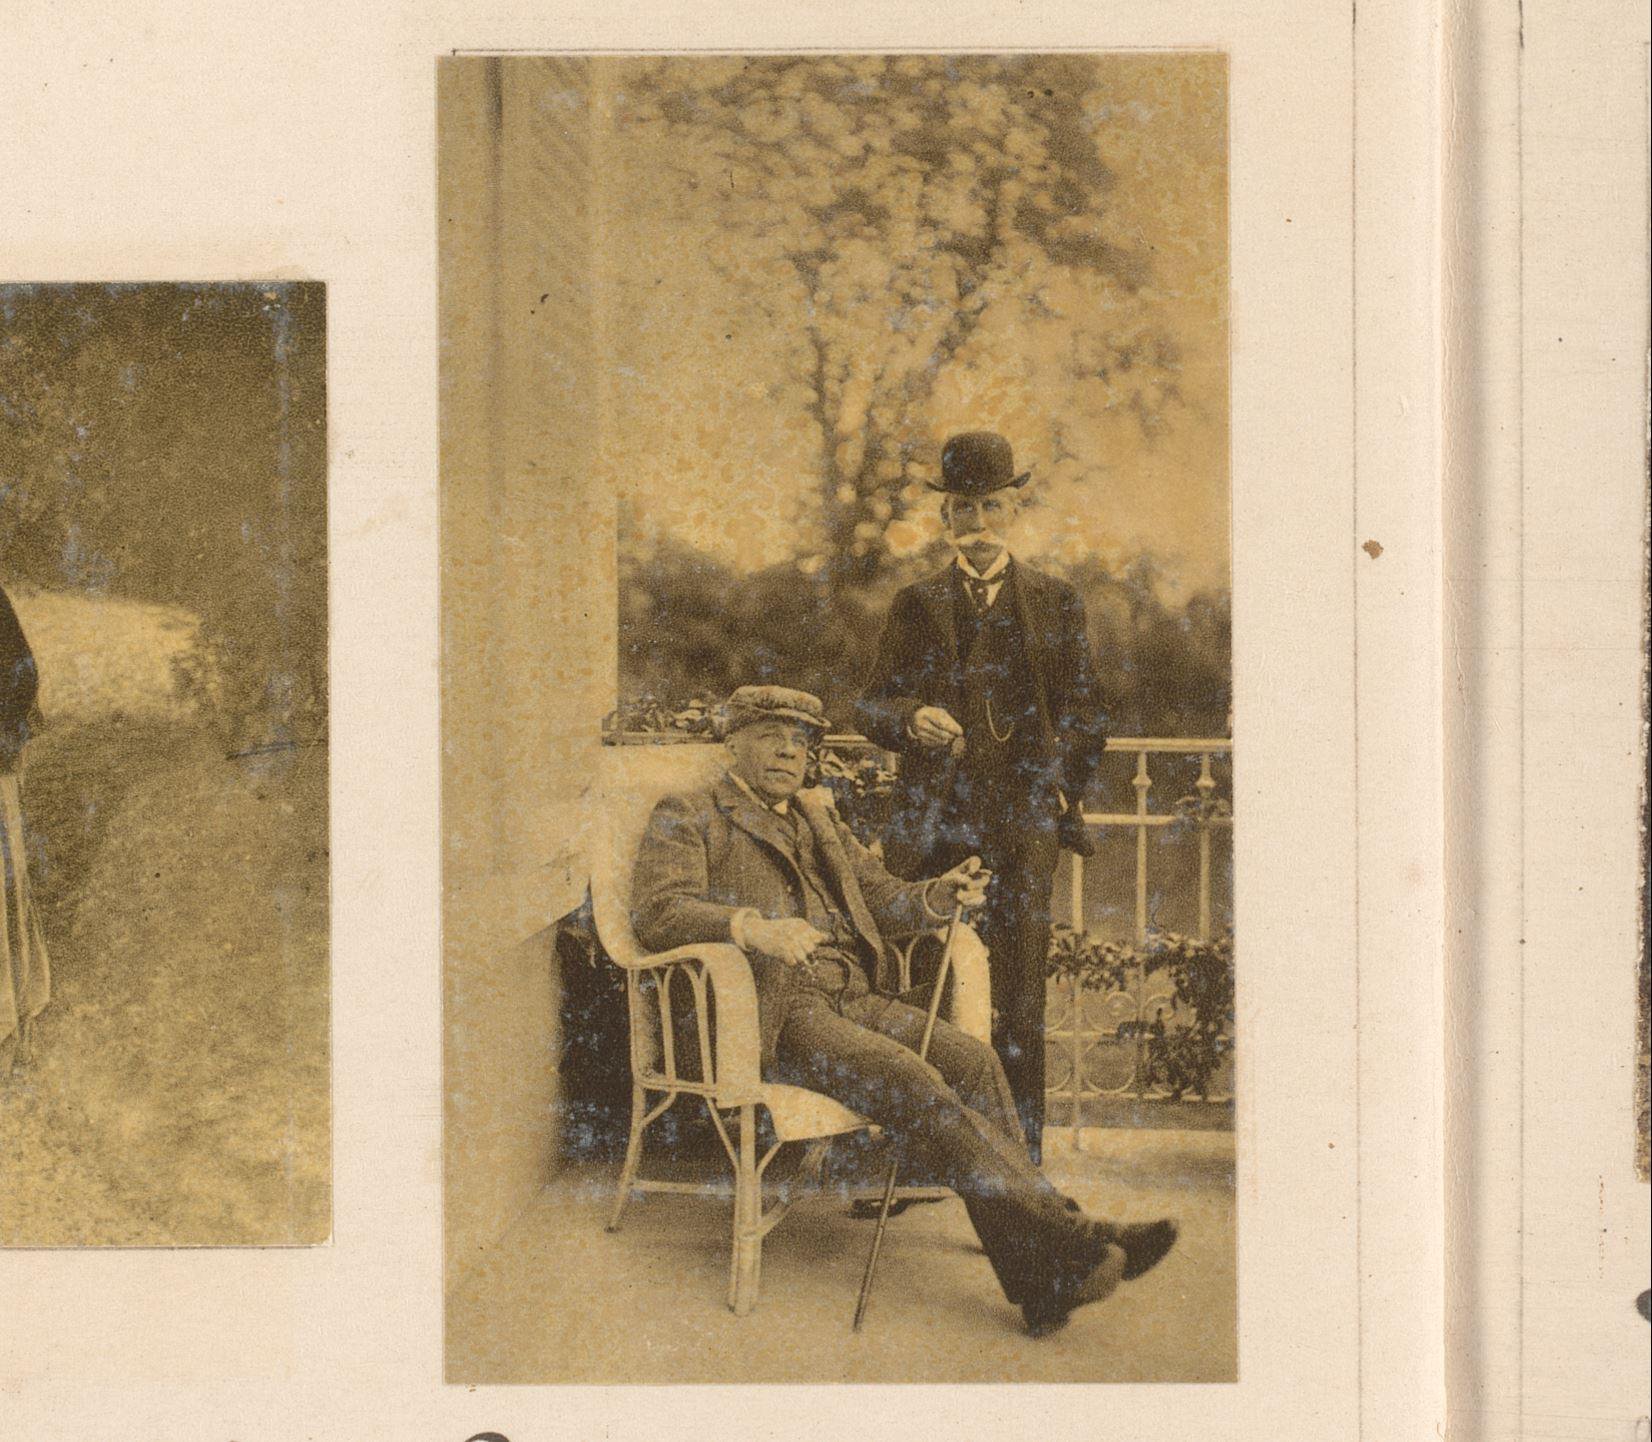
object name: album leaf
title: Coquelin Aîné (en 1895)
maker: Anonymous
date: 1895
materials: paper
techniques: rotogravure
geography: france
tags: portrait of actor, actress, france